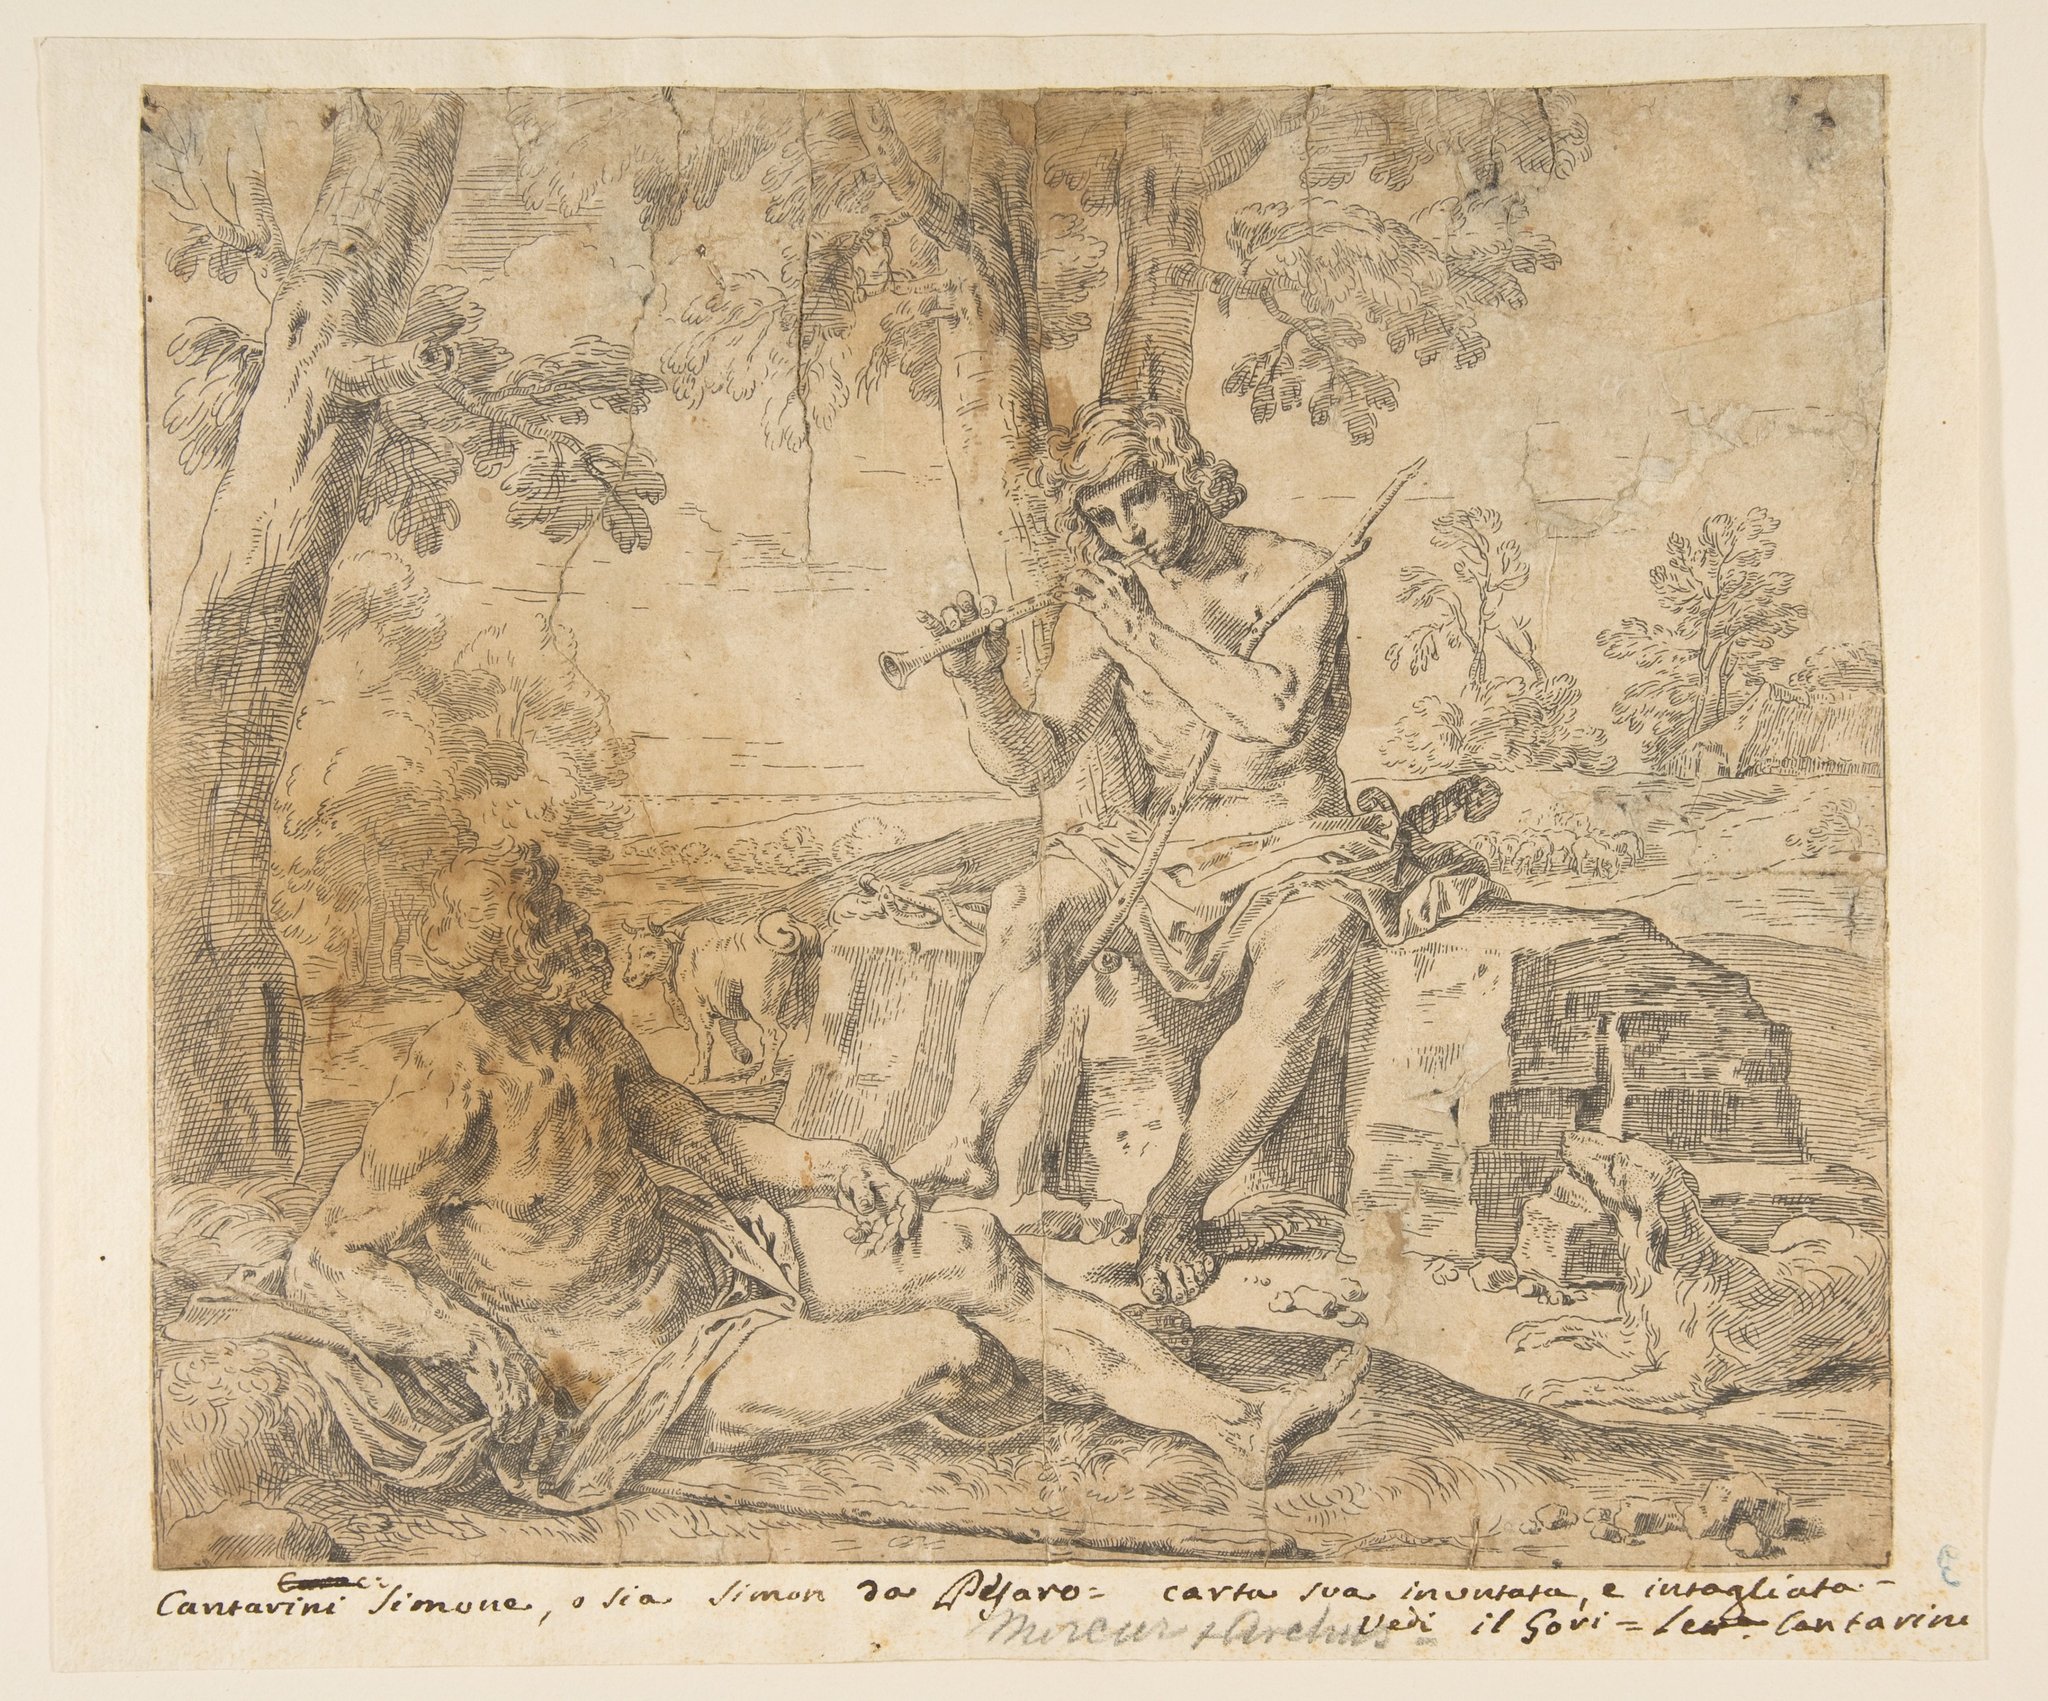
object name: print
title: Mercury and Argus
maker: simone cantarini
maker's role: artist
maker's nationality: italian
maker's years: 1612-1648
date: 1630-1648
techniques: etching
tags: men,mercury,dogs,trees